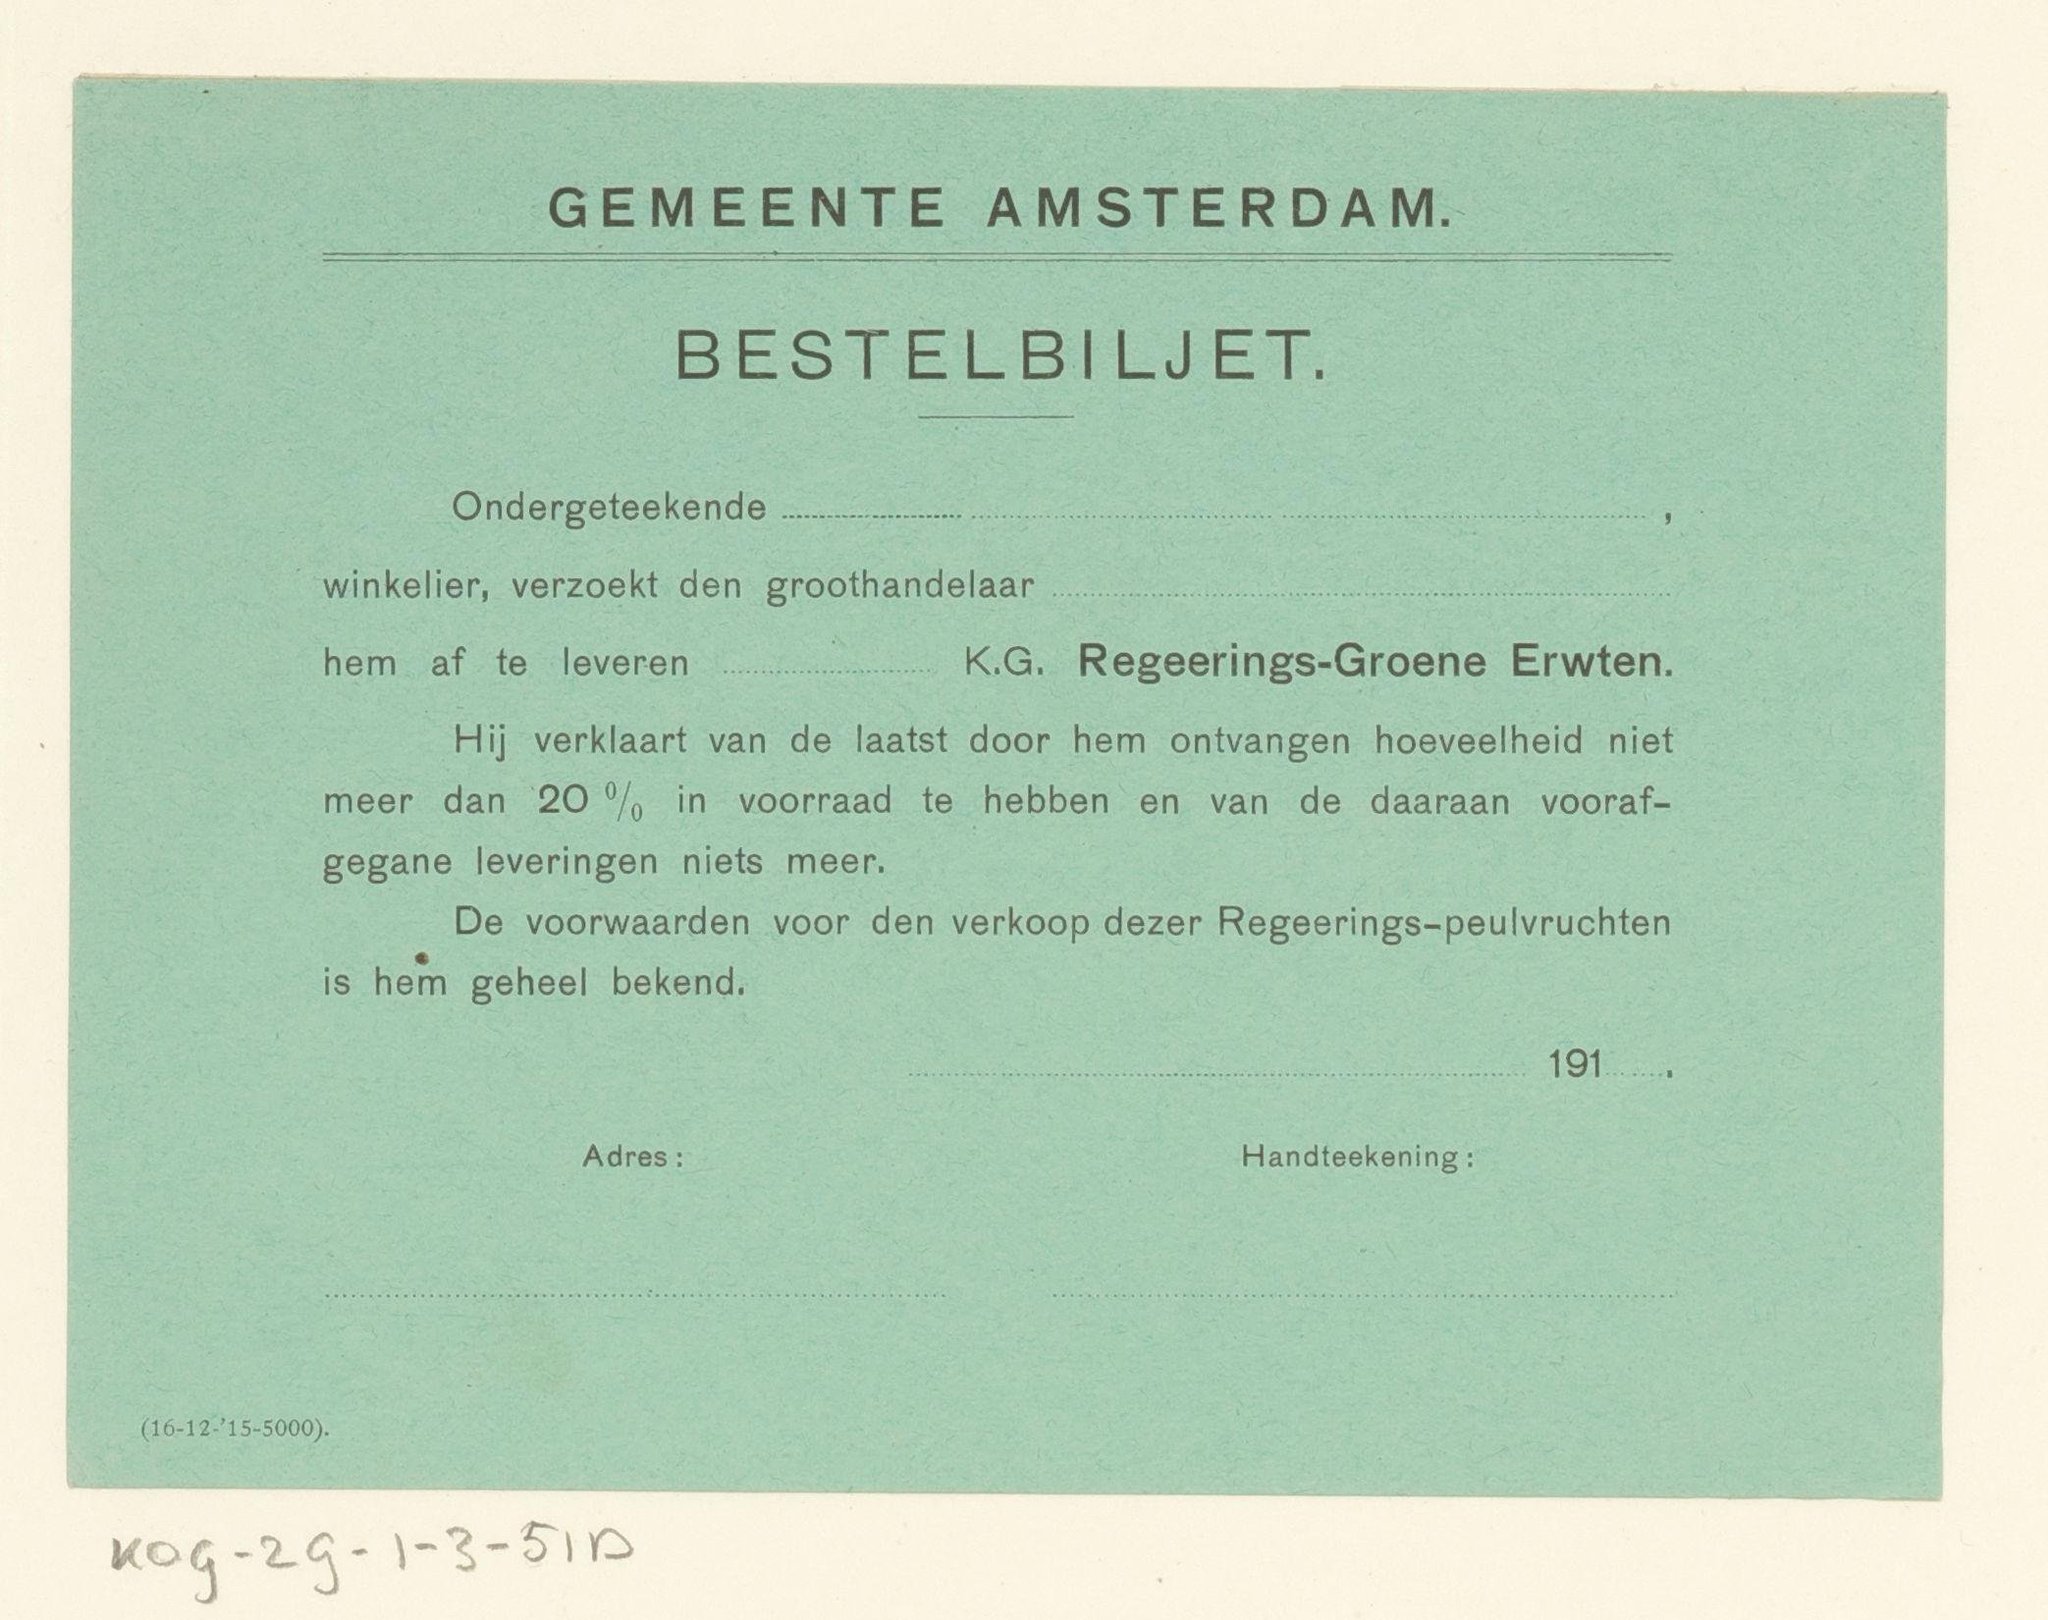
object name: document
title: Aanvraagformulier voor Regeerings-Groene Erwten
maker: Anonymous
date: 1915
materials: paper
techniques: letterpress printing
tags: seed: pea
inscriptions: stamp, collector's mark: Lugt 1641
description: Aanvraagformulier voor Regeerings-Groene Erwten in de gemeente Amsterdam. De winkelier mag niet meer dan 20% van zijn laatst ontvangen bonen in voorraad hebben. Tijdens de crisisjaren in de Eerste Wereldoorlog hield de regering de prijzen van bepaalde voedingsmiddelen kunstmatig laag. Onderwerpsrubrieken binnen de Atlas Zeden en Gewoonten: Regeering, Crisismaatregelen gedurende den wereldoorlog 1914-1919.